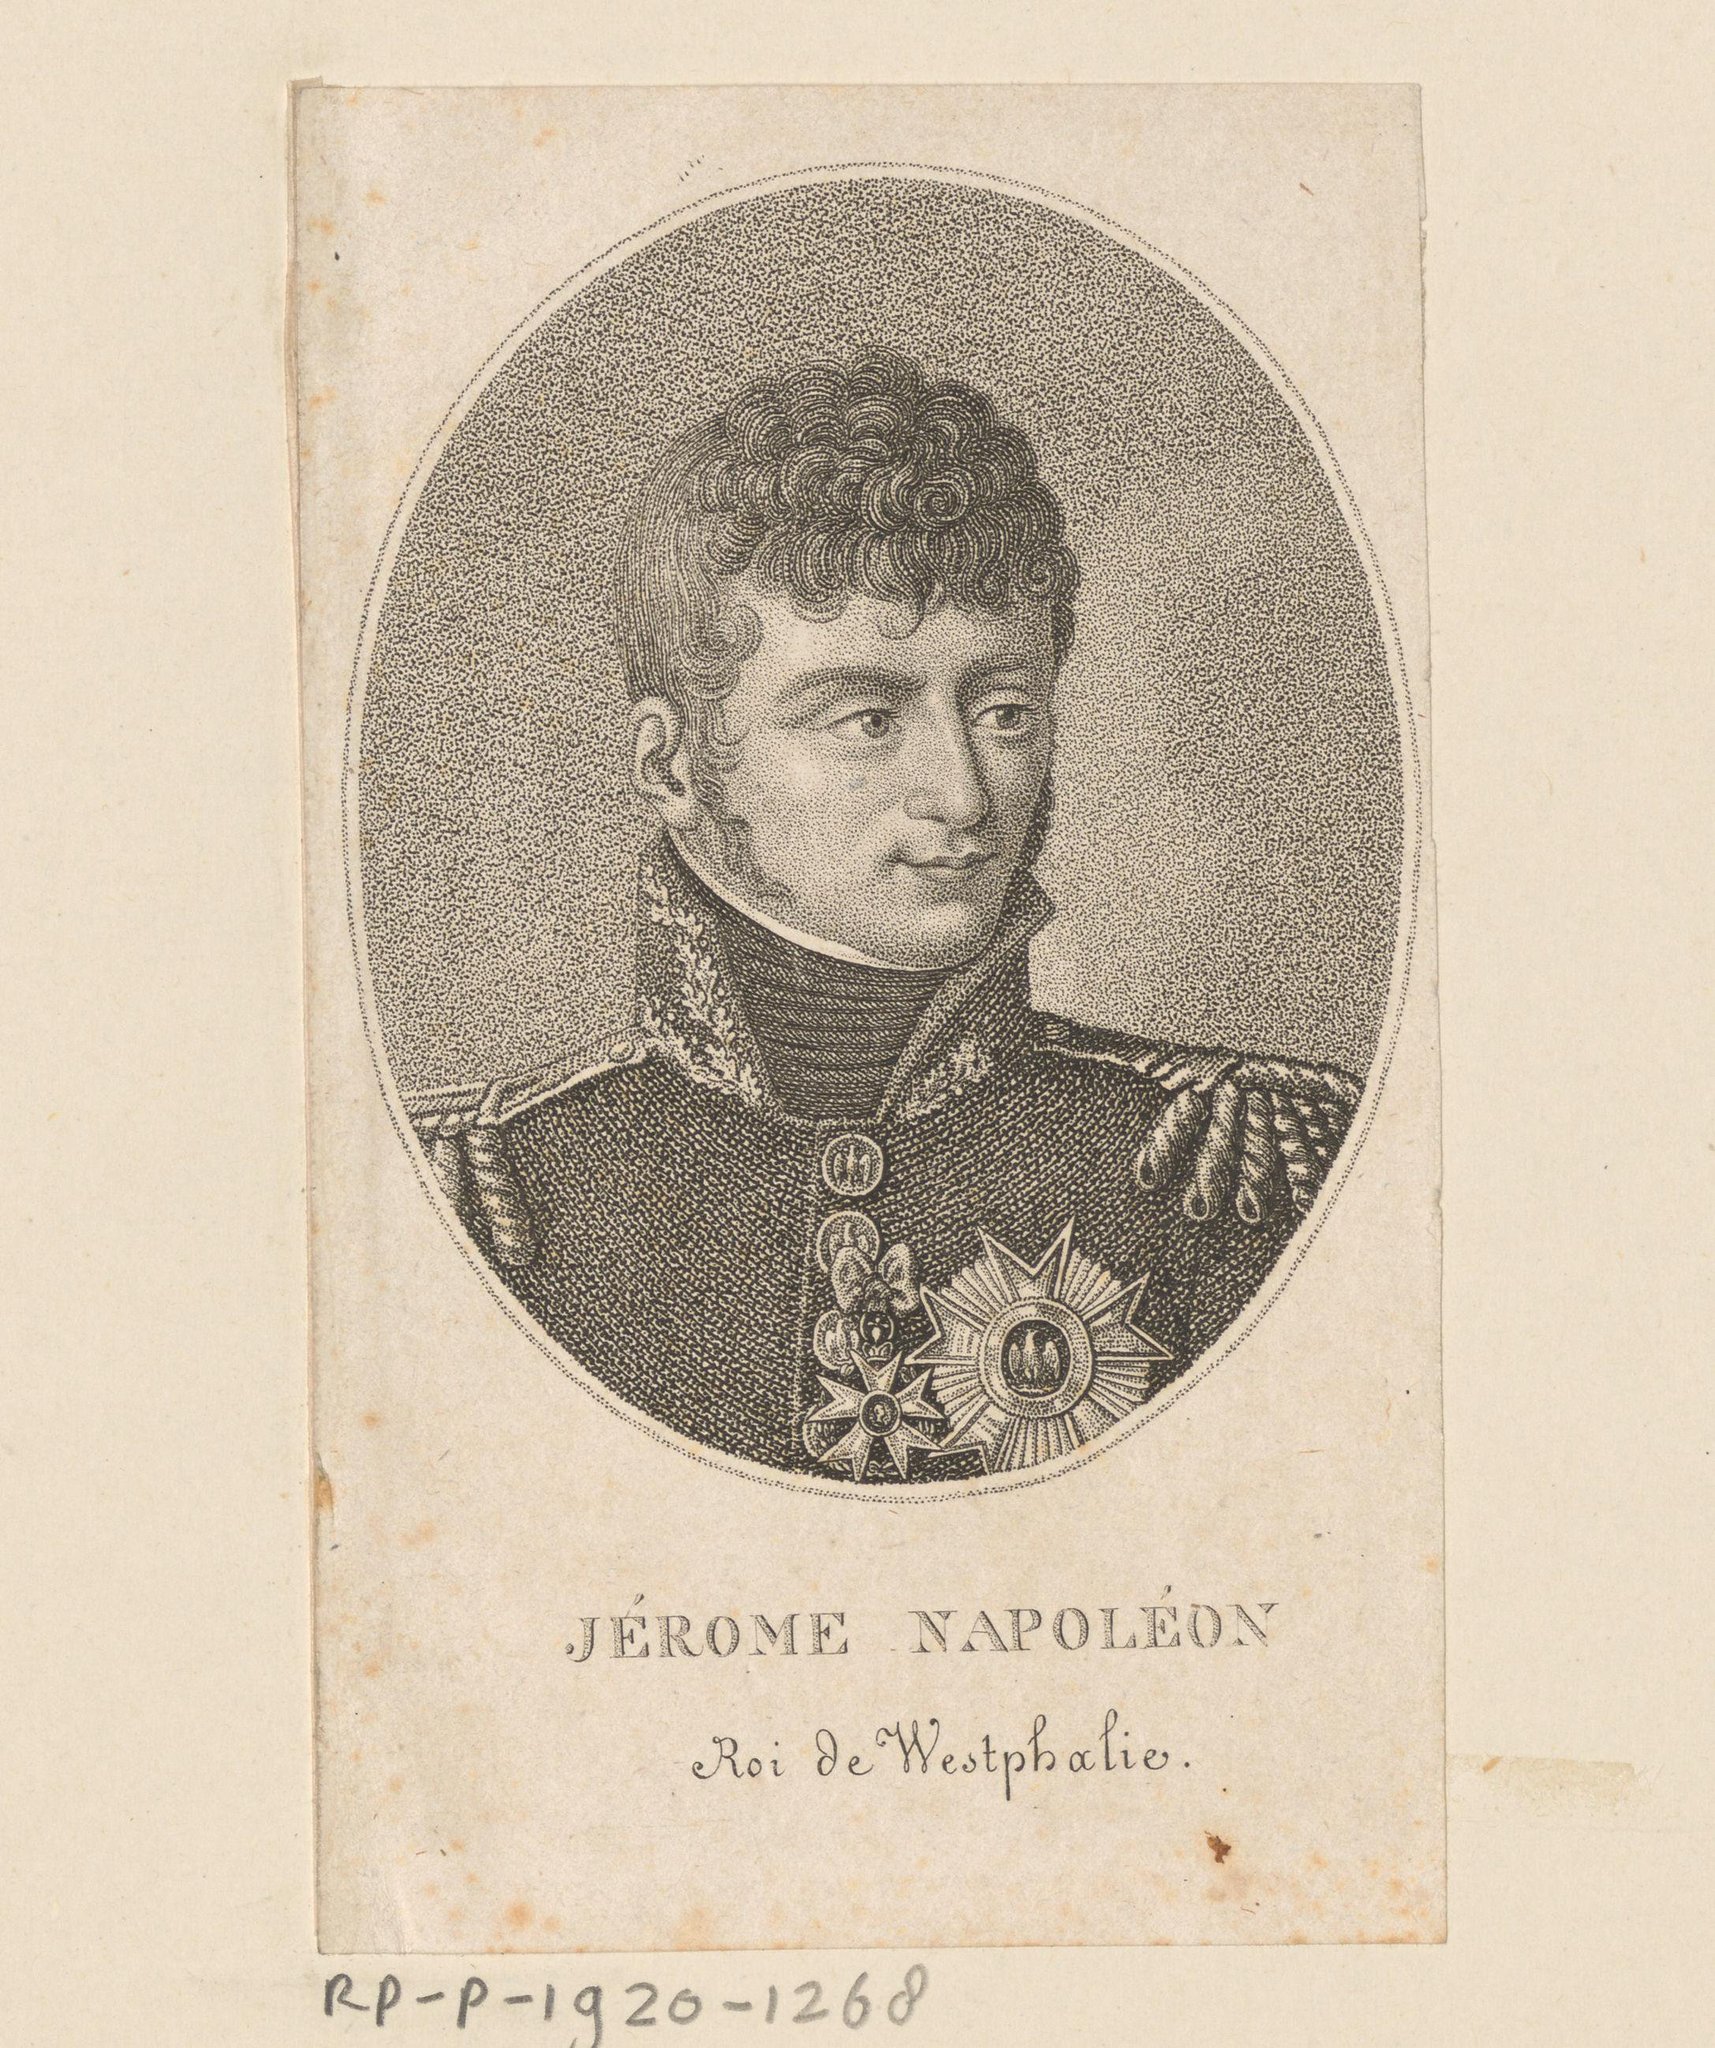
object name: print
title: Portret van Jérôme Bonaparte, koning van Westfalen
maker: Anonymous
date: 1807-1850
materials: paper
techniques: etching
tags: knighthood order, historical persons, king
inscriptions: collector's mark: Lugt 2228